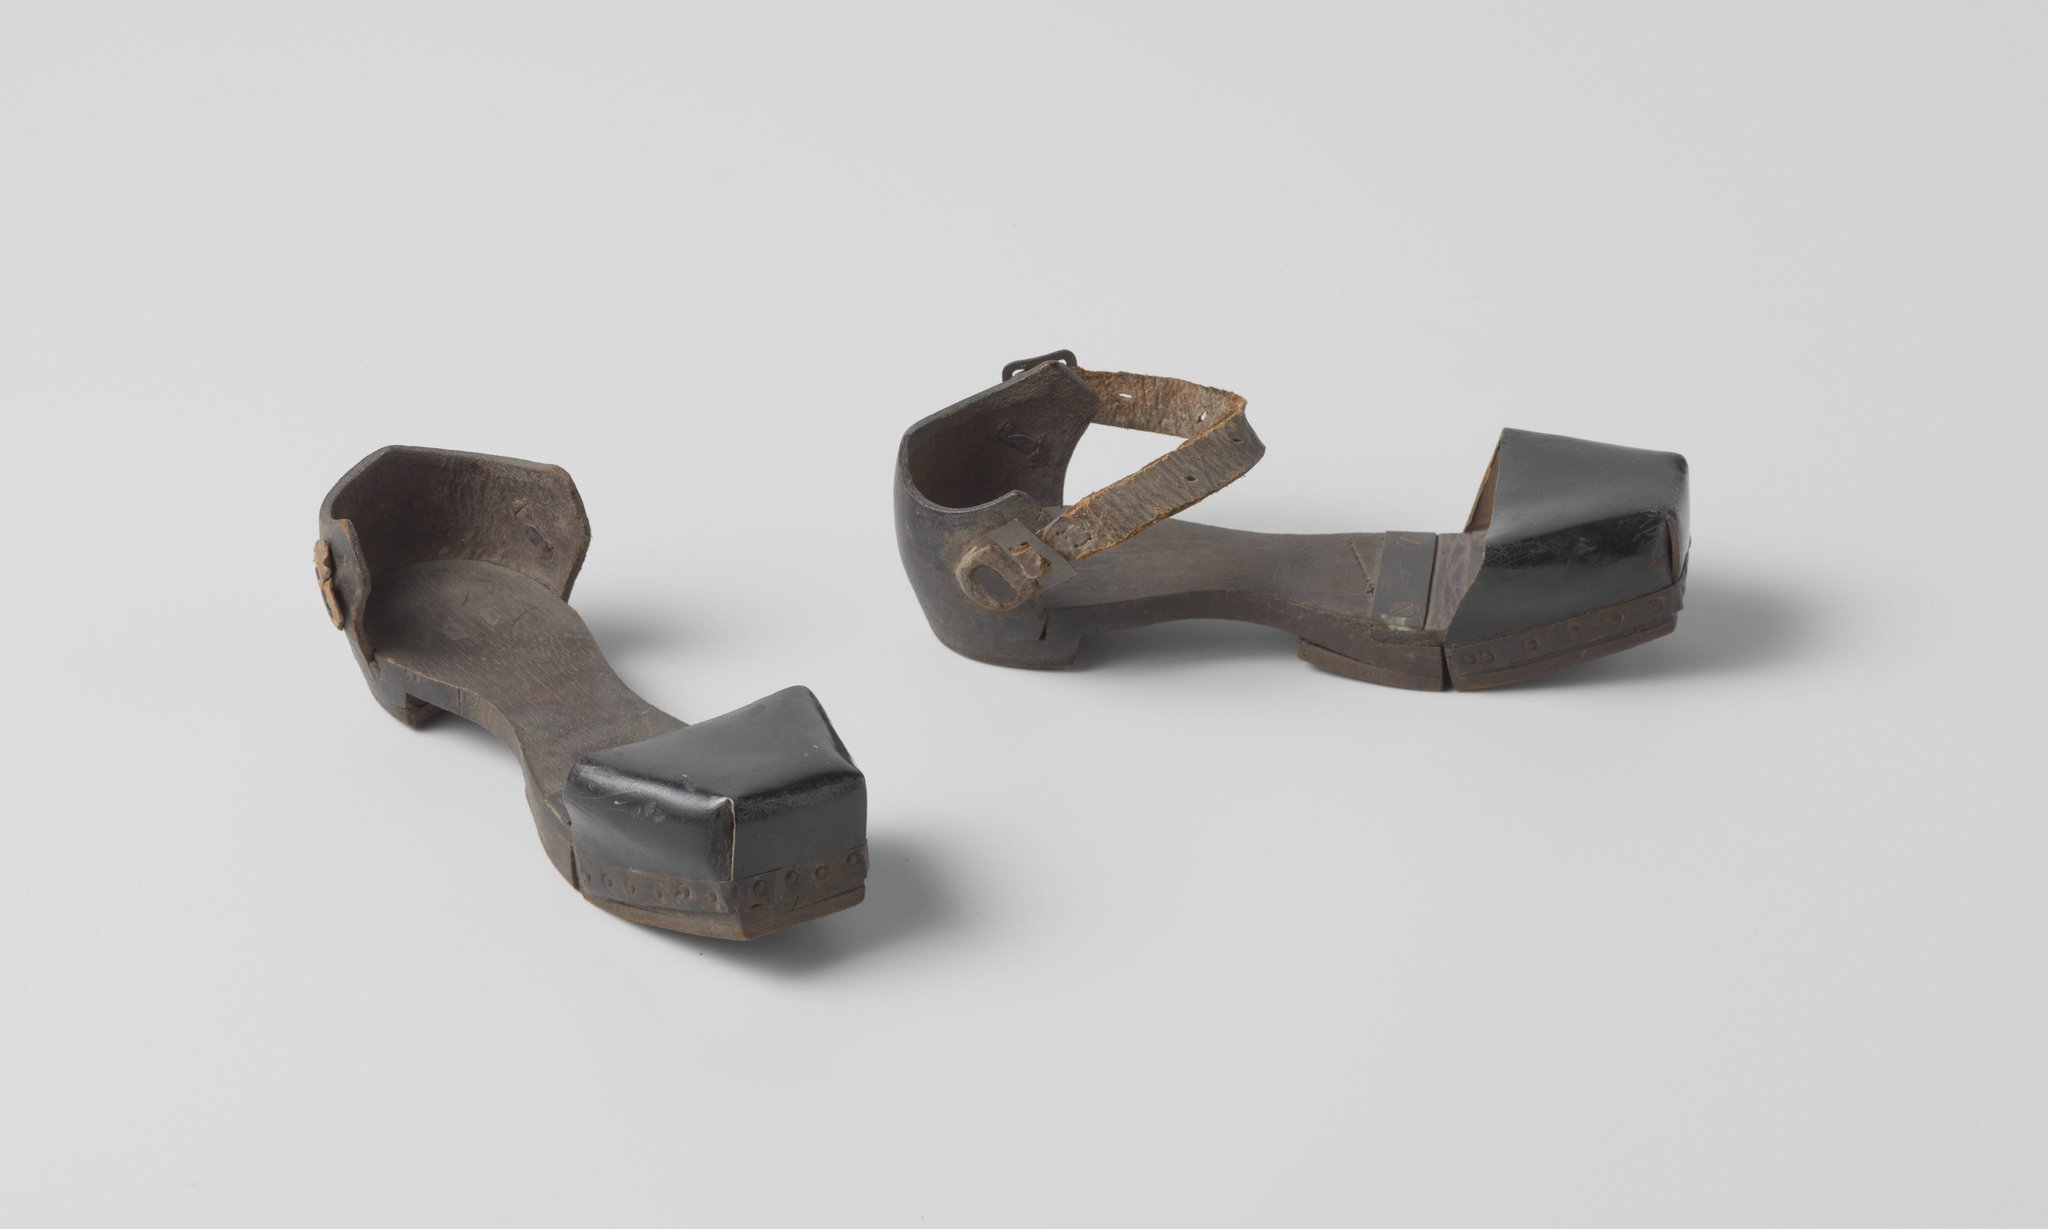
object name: childrenswear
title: Pair of mules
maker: Anonymous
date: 1800-1900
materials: copper, leather, wood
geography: netherlands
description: Schoen of muil met houten zolen die in de buiging van de voet scharniert. Voorzool en hak met ller bekleed, vierkante neus. Hielband en gespen van koper. Gemerkt: 154. Kindermodel